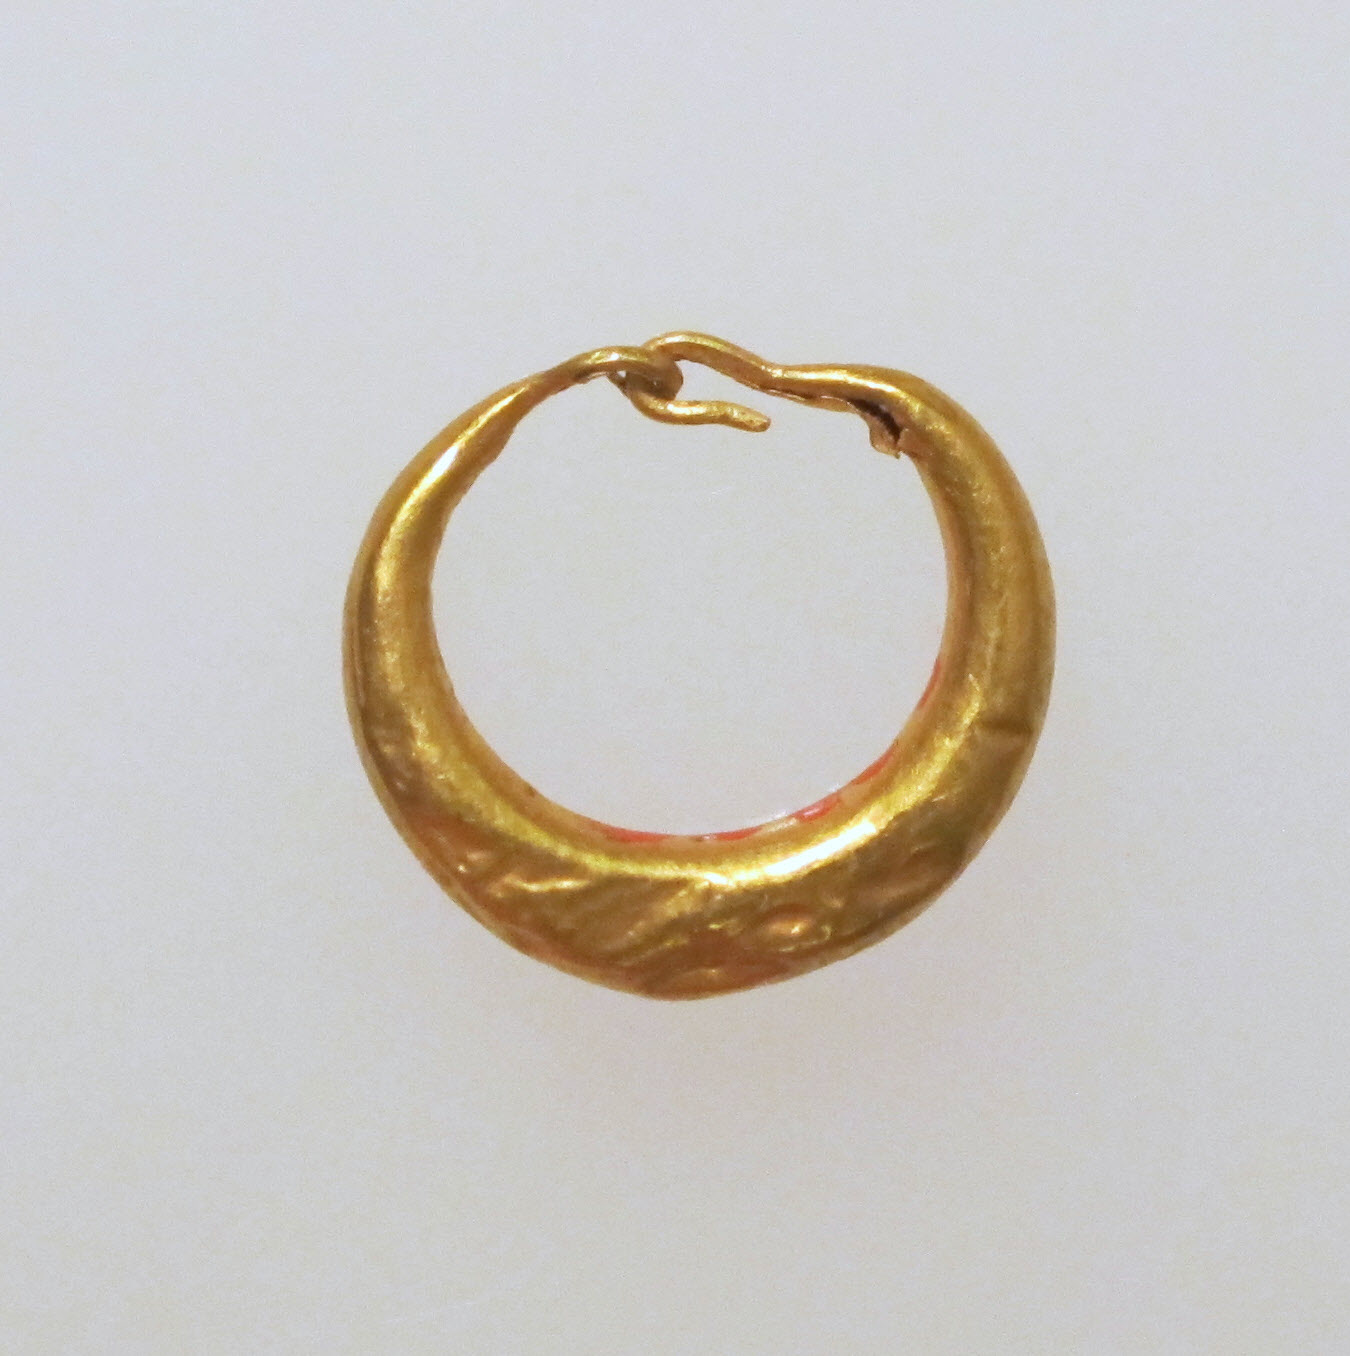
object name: earring loop type, plain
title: Earring-loop type, plain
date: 7000 BCE-330 CE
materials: gold